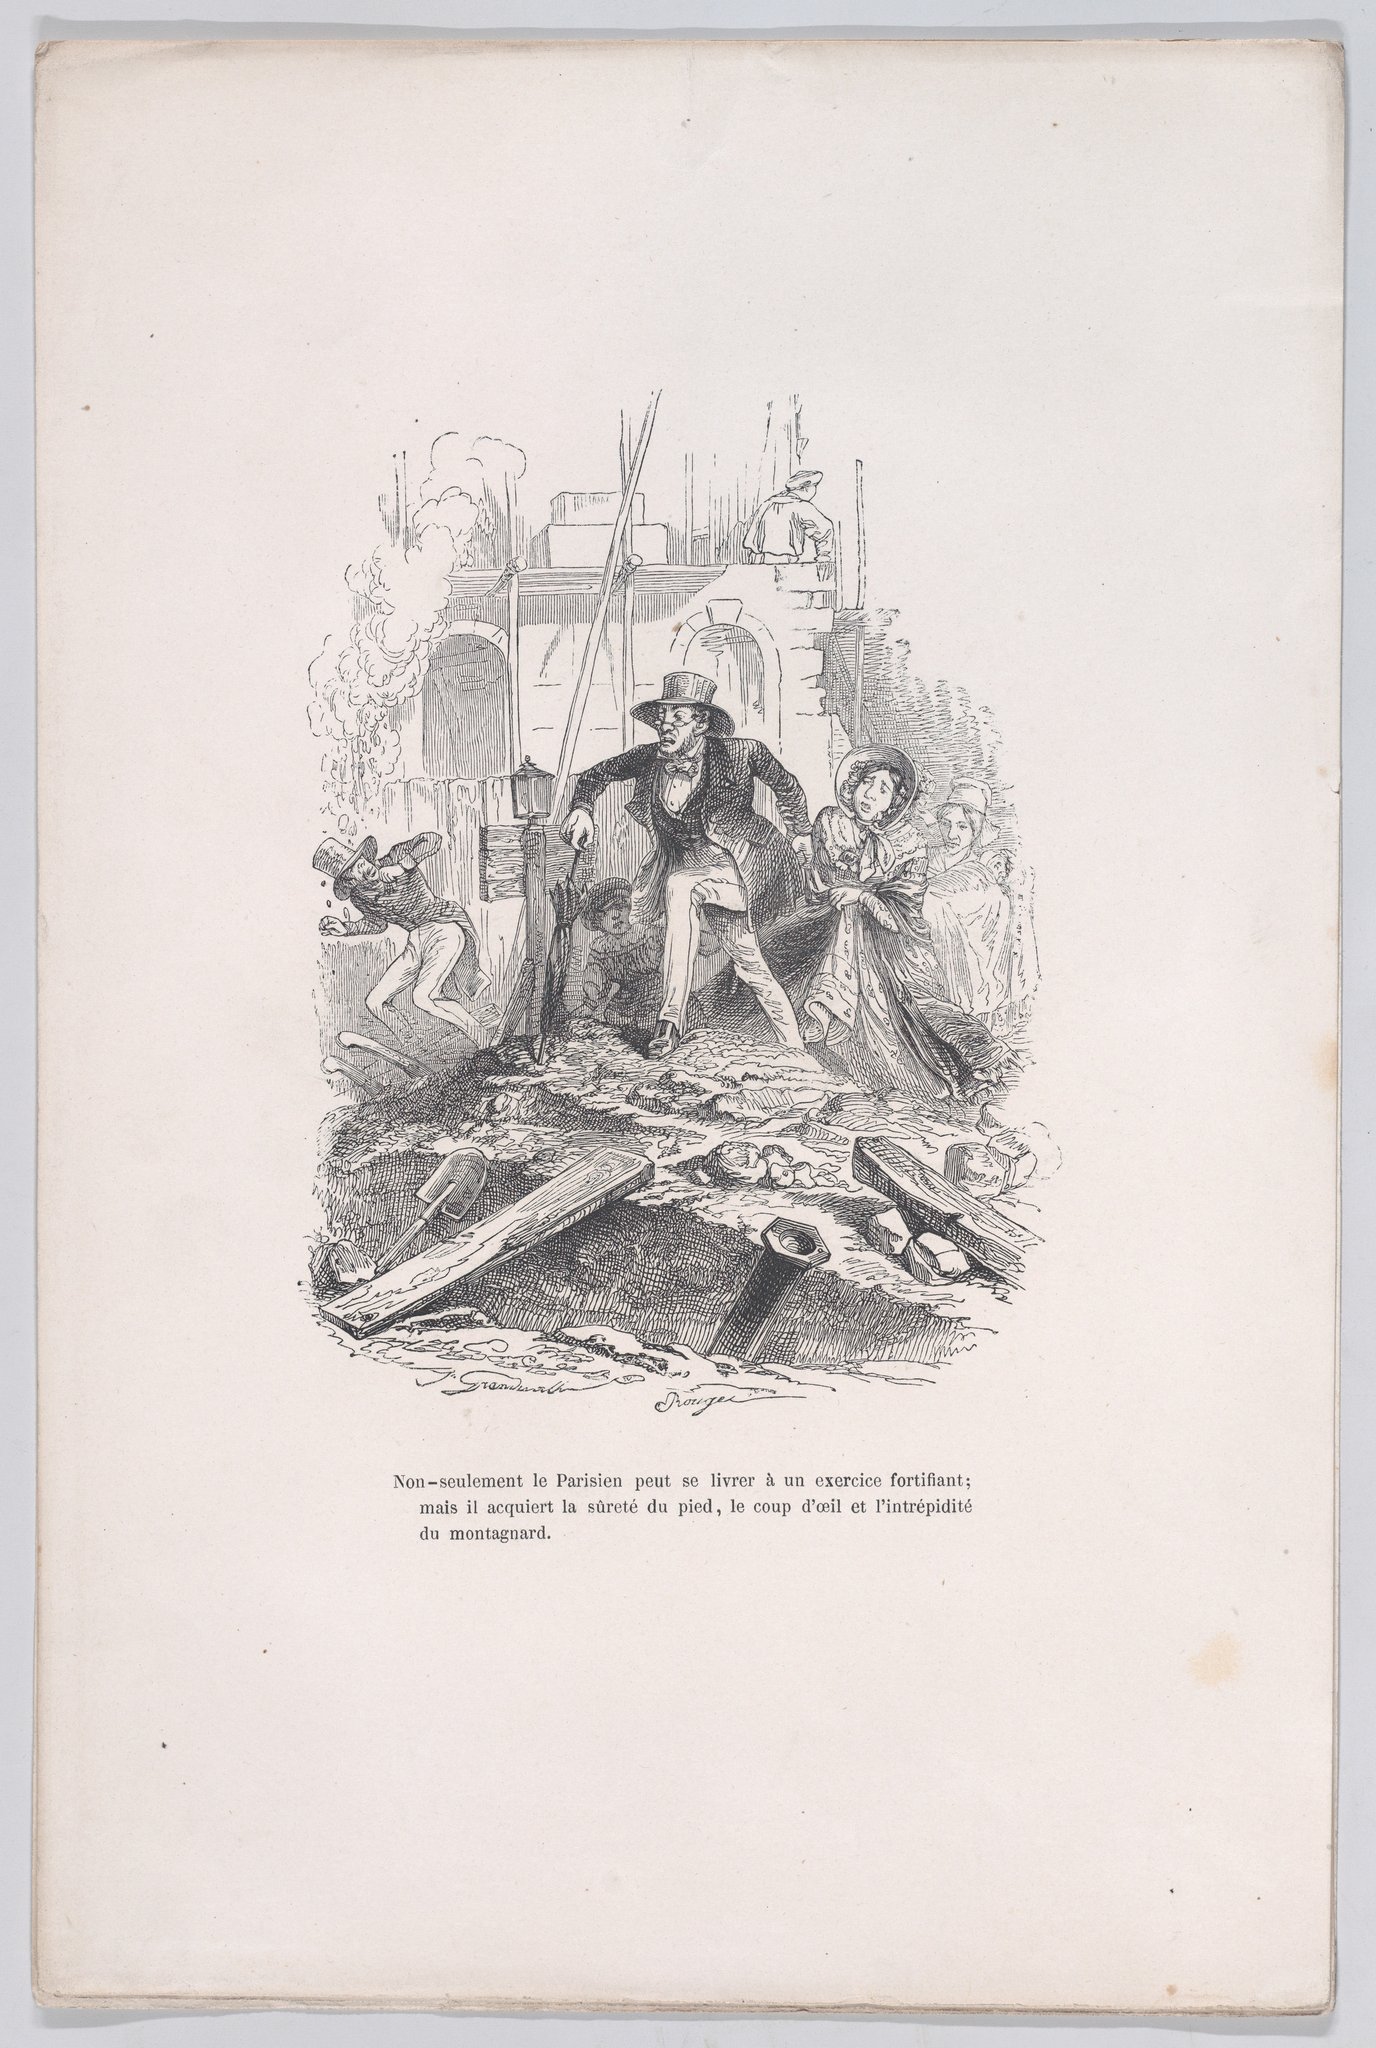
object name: print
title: Not only can the Parisian engage in a strengthening exercise; but he acquires the safety of the foot, the glance and the intrepidity of the mountaineer, from "Little Miseries of Human Life"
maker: j. j. grandville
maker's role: illustrator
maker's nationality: french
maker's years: 1803-1847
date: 1843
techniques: engraving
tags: men,women